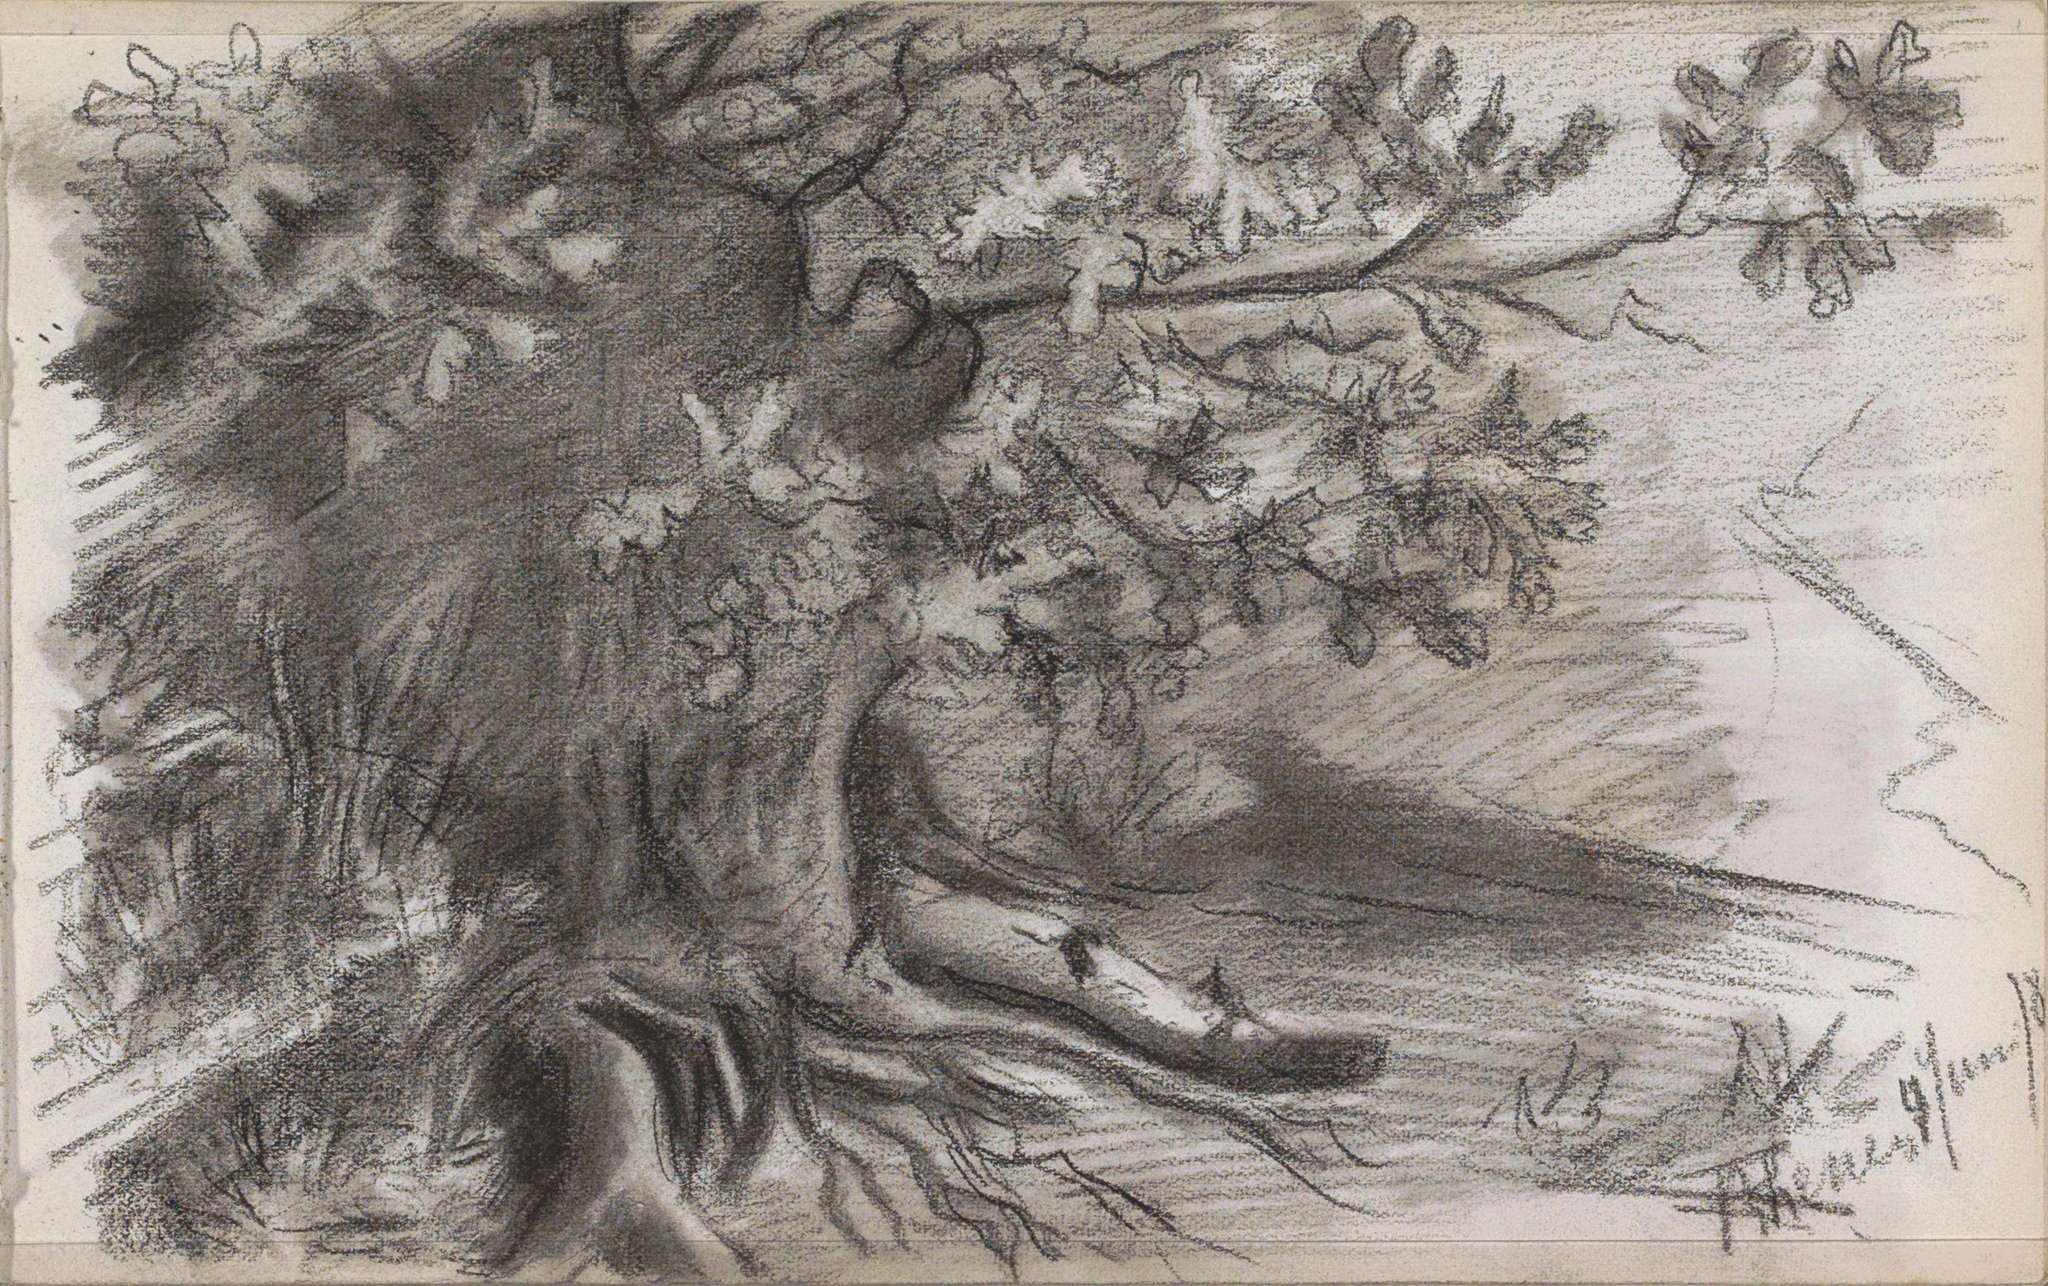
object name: sketchbook leaf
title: Landschap met een grote boom in Rhenen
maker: willem witsen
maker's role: draughtsman, painter, print maker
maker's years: 1860-1923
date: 1878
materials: chalk, paper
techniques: stumping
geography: rhenen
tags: trees, forest, wood, rhenen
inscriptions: annotation: ‘Rhenen’, date: ‘4 Juni 78’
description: Pagina 11 uit een schetsboek met 23 bladen.